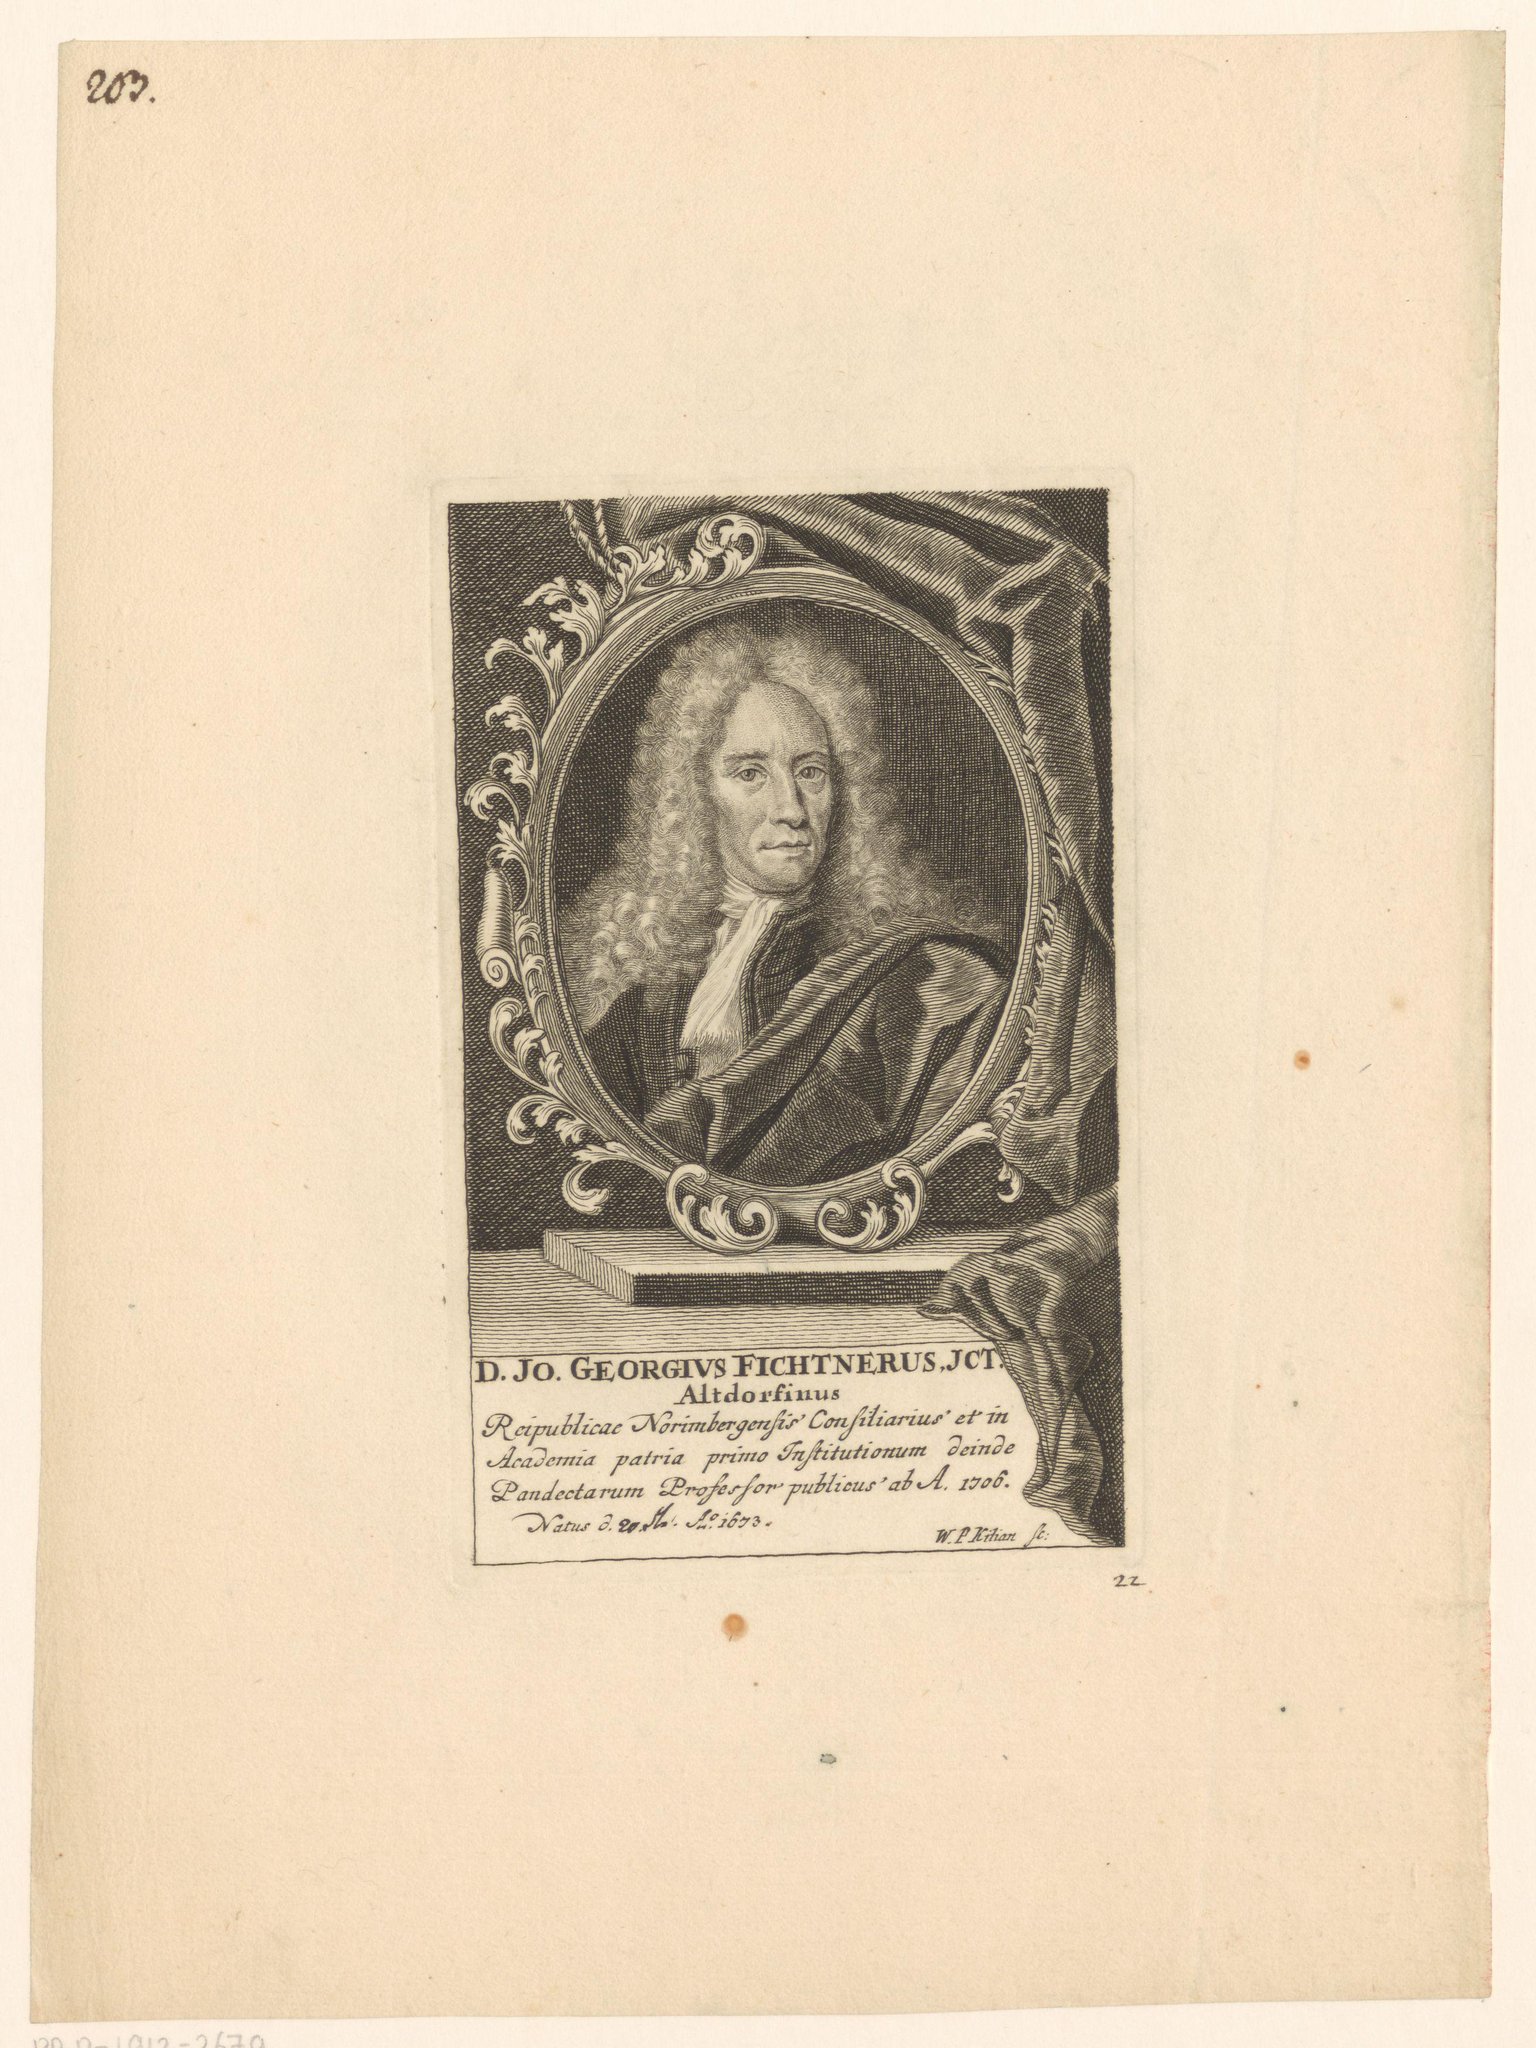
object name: print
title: Portret van Johann Georg Fichtner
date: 1706-1732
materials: paper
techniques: engraving, etching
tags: further education (+ portrait of teacher, professor), historical persons, lawyer, attorney at law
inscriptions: collector's mark: Lugt 2228, number: ‘22’